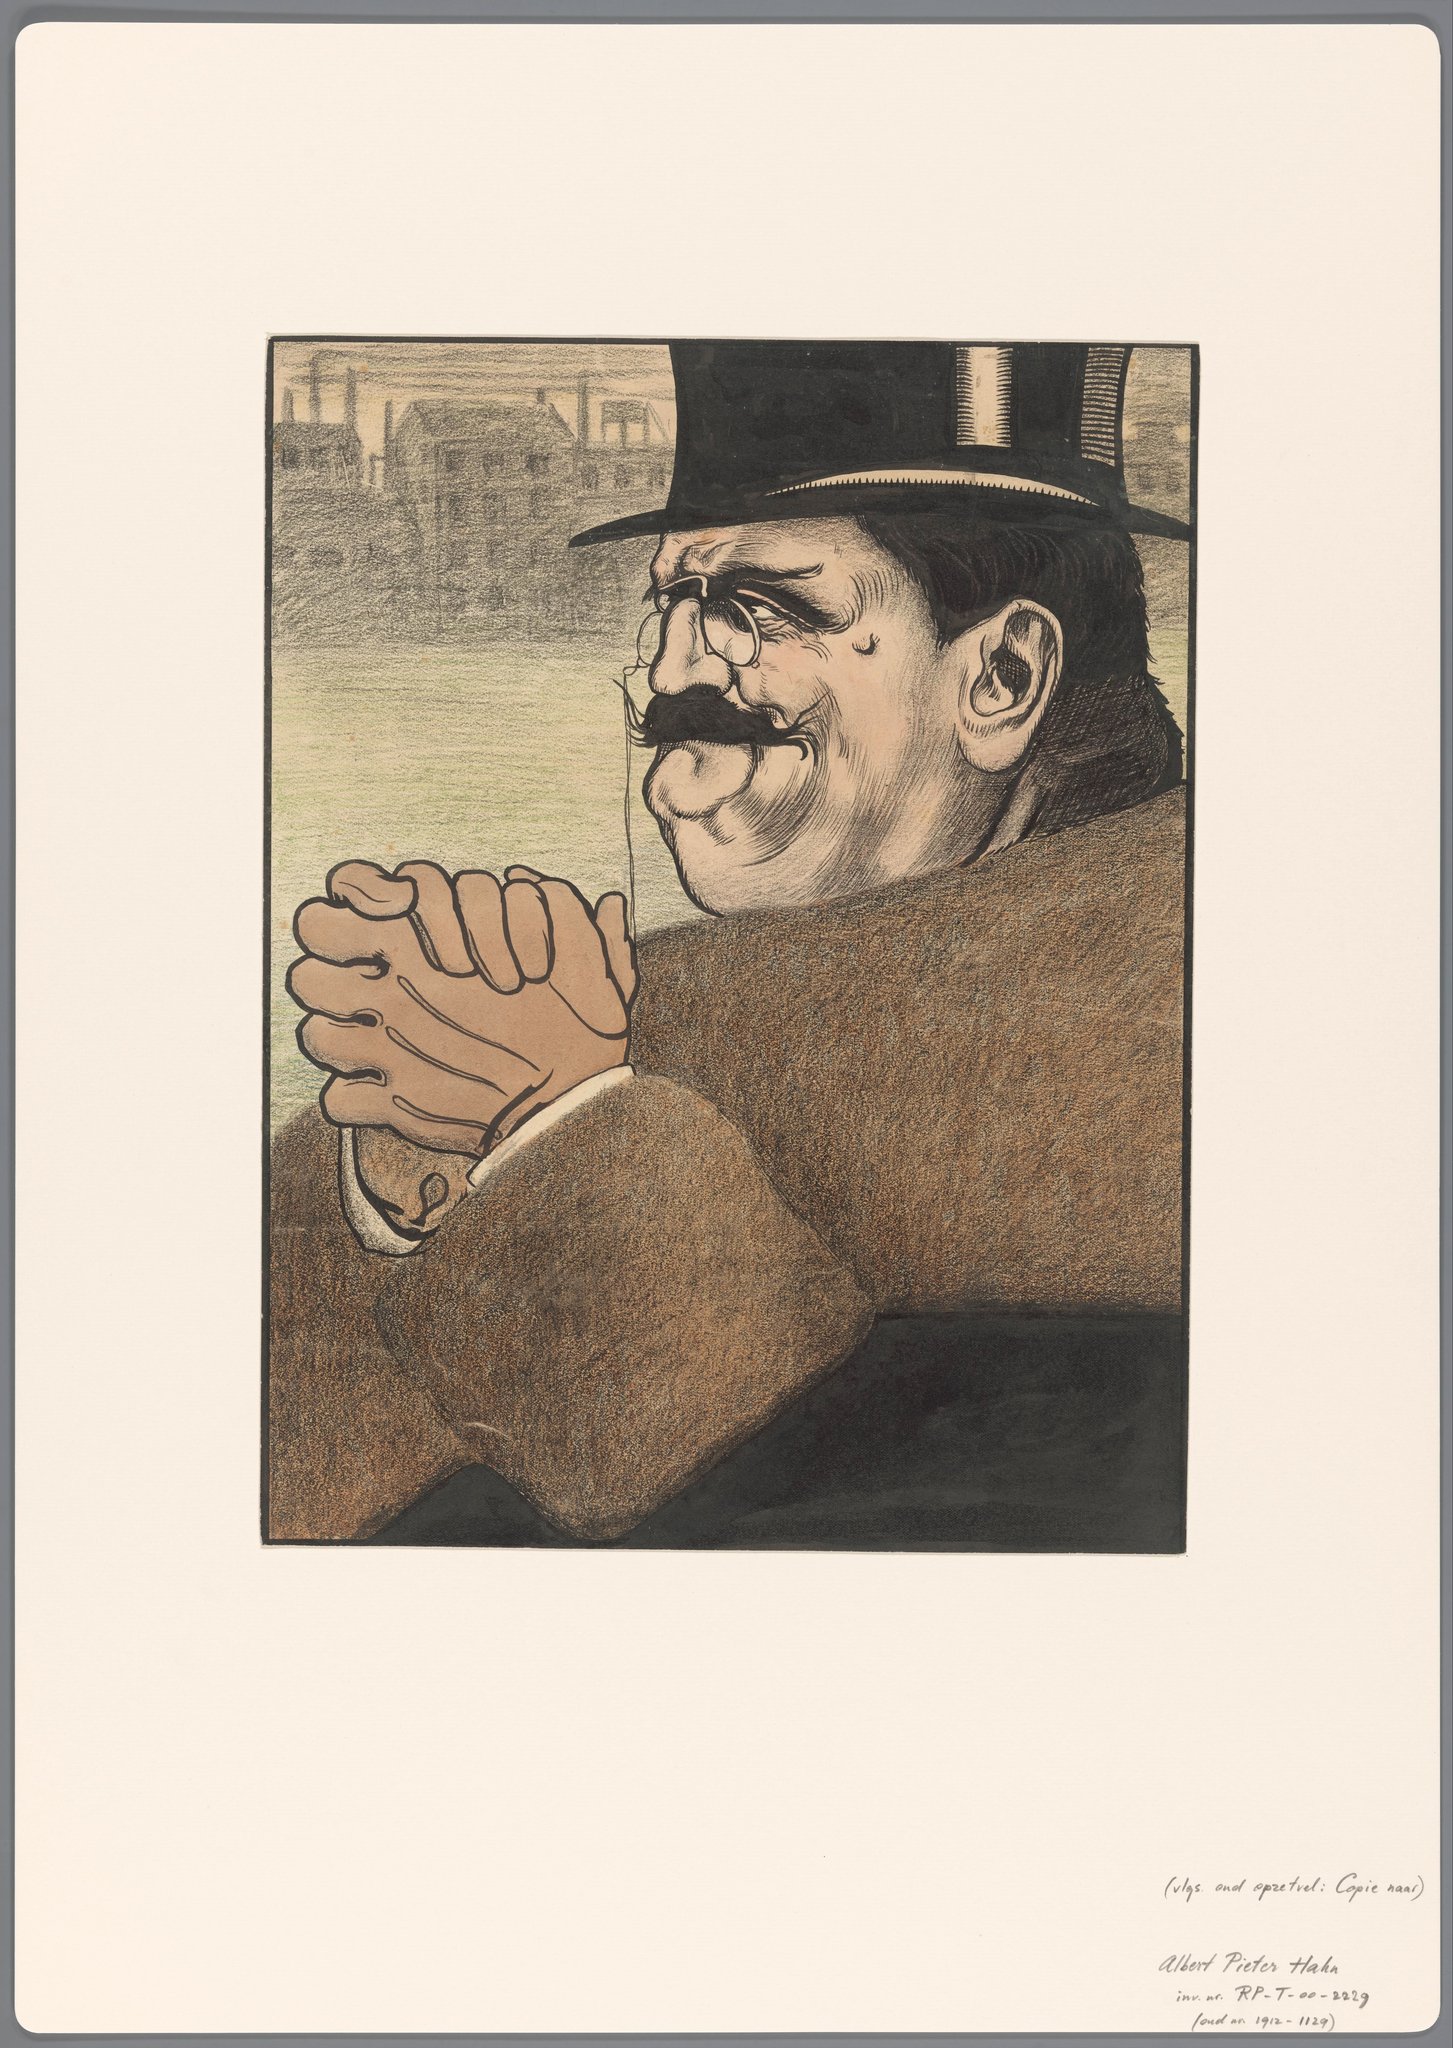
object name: drawing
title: Ontwerp voor een politieke spotprent: de kapitalist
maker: albert hahn (i)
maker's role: draughtsman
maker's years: 1877-1918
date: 1904-1905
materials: cardboard, chalk, ink, pencil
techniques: brush, pen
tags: the hague, abraham kuyper, war of classes, political caricatures and satires